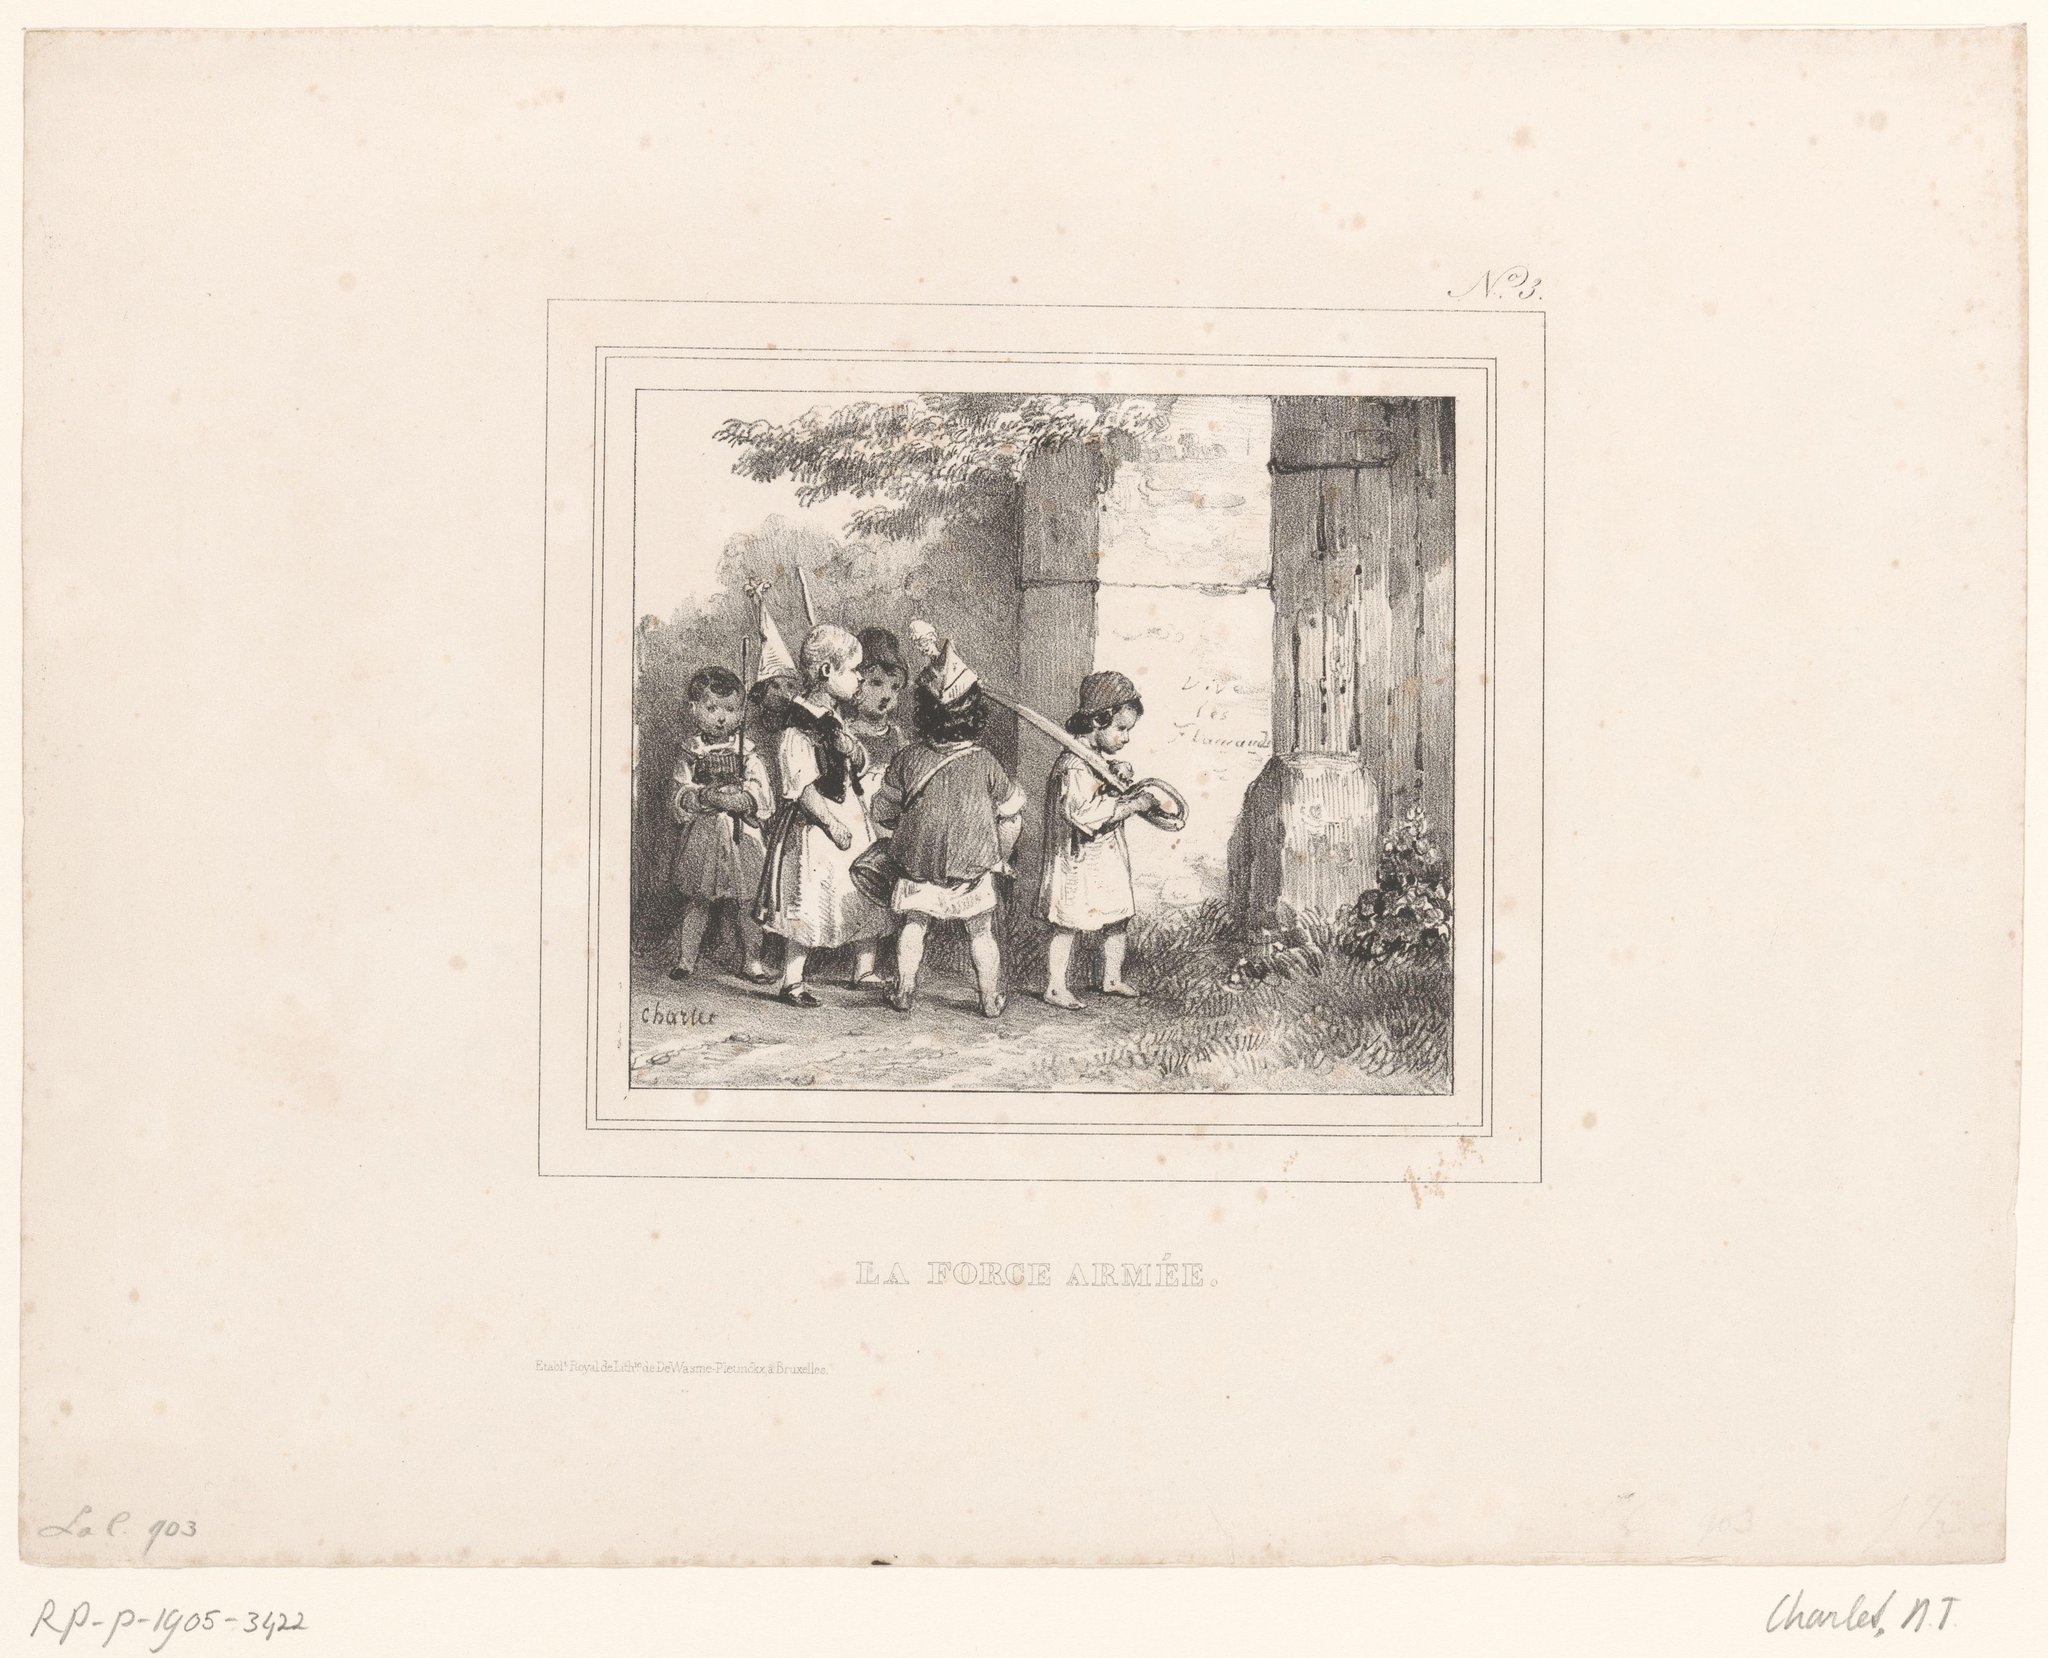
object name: print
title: La force armée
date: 1837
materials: paper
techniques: lithograph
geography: paris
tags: child, games using special objects (marbles, top, hoop, etc.)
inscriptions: collector's mark: Lugt 2228a